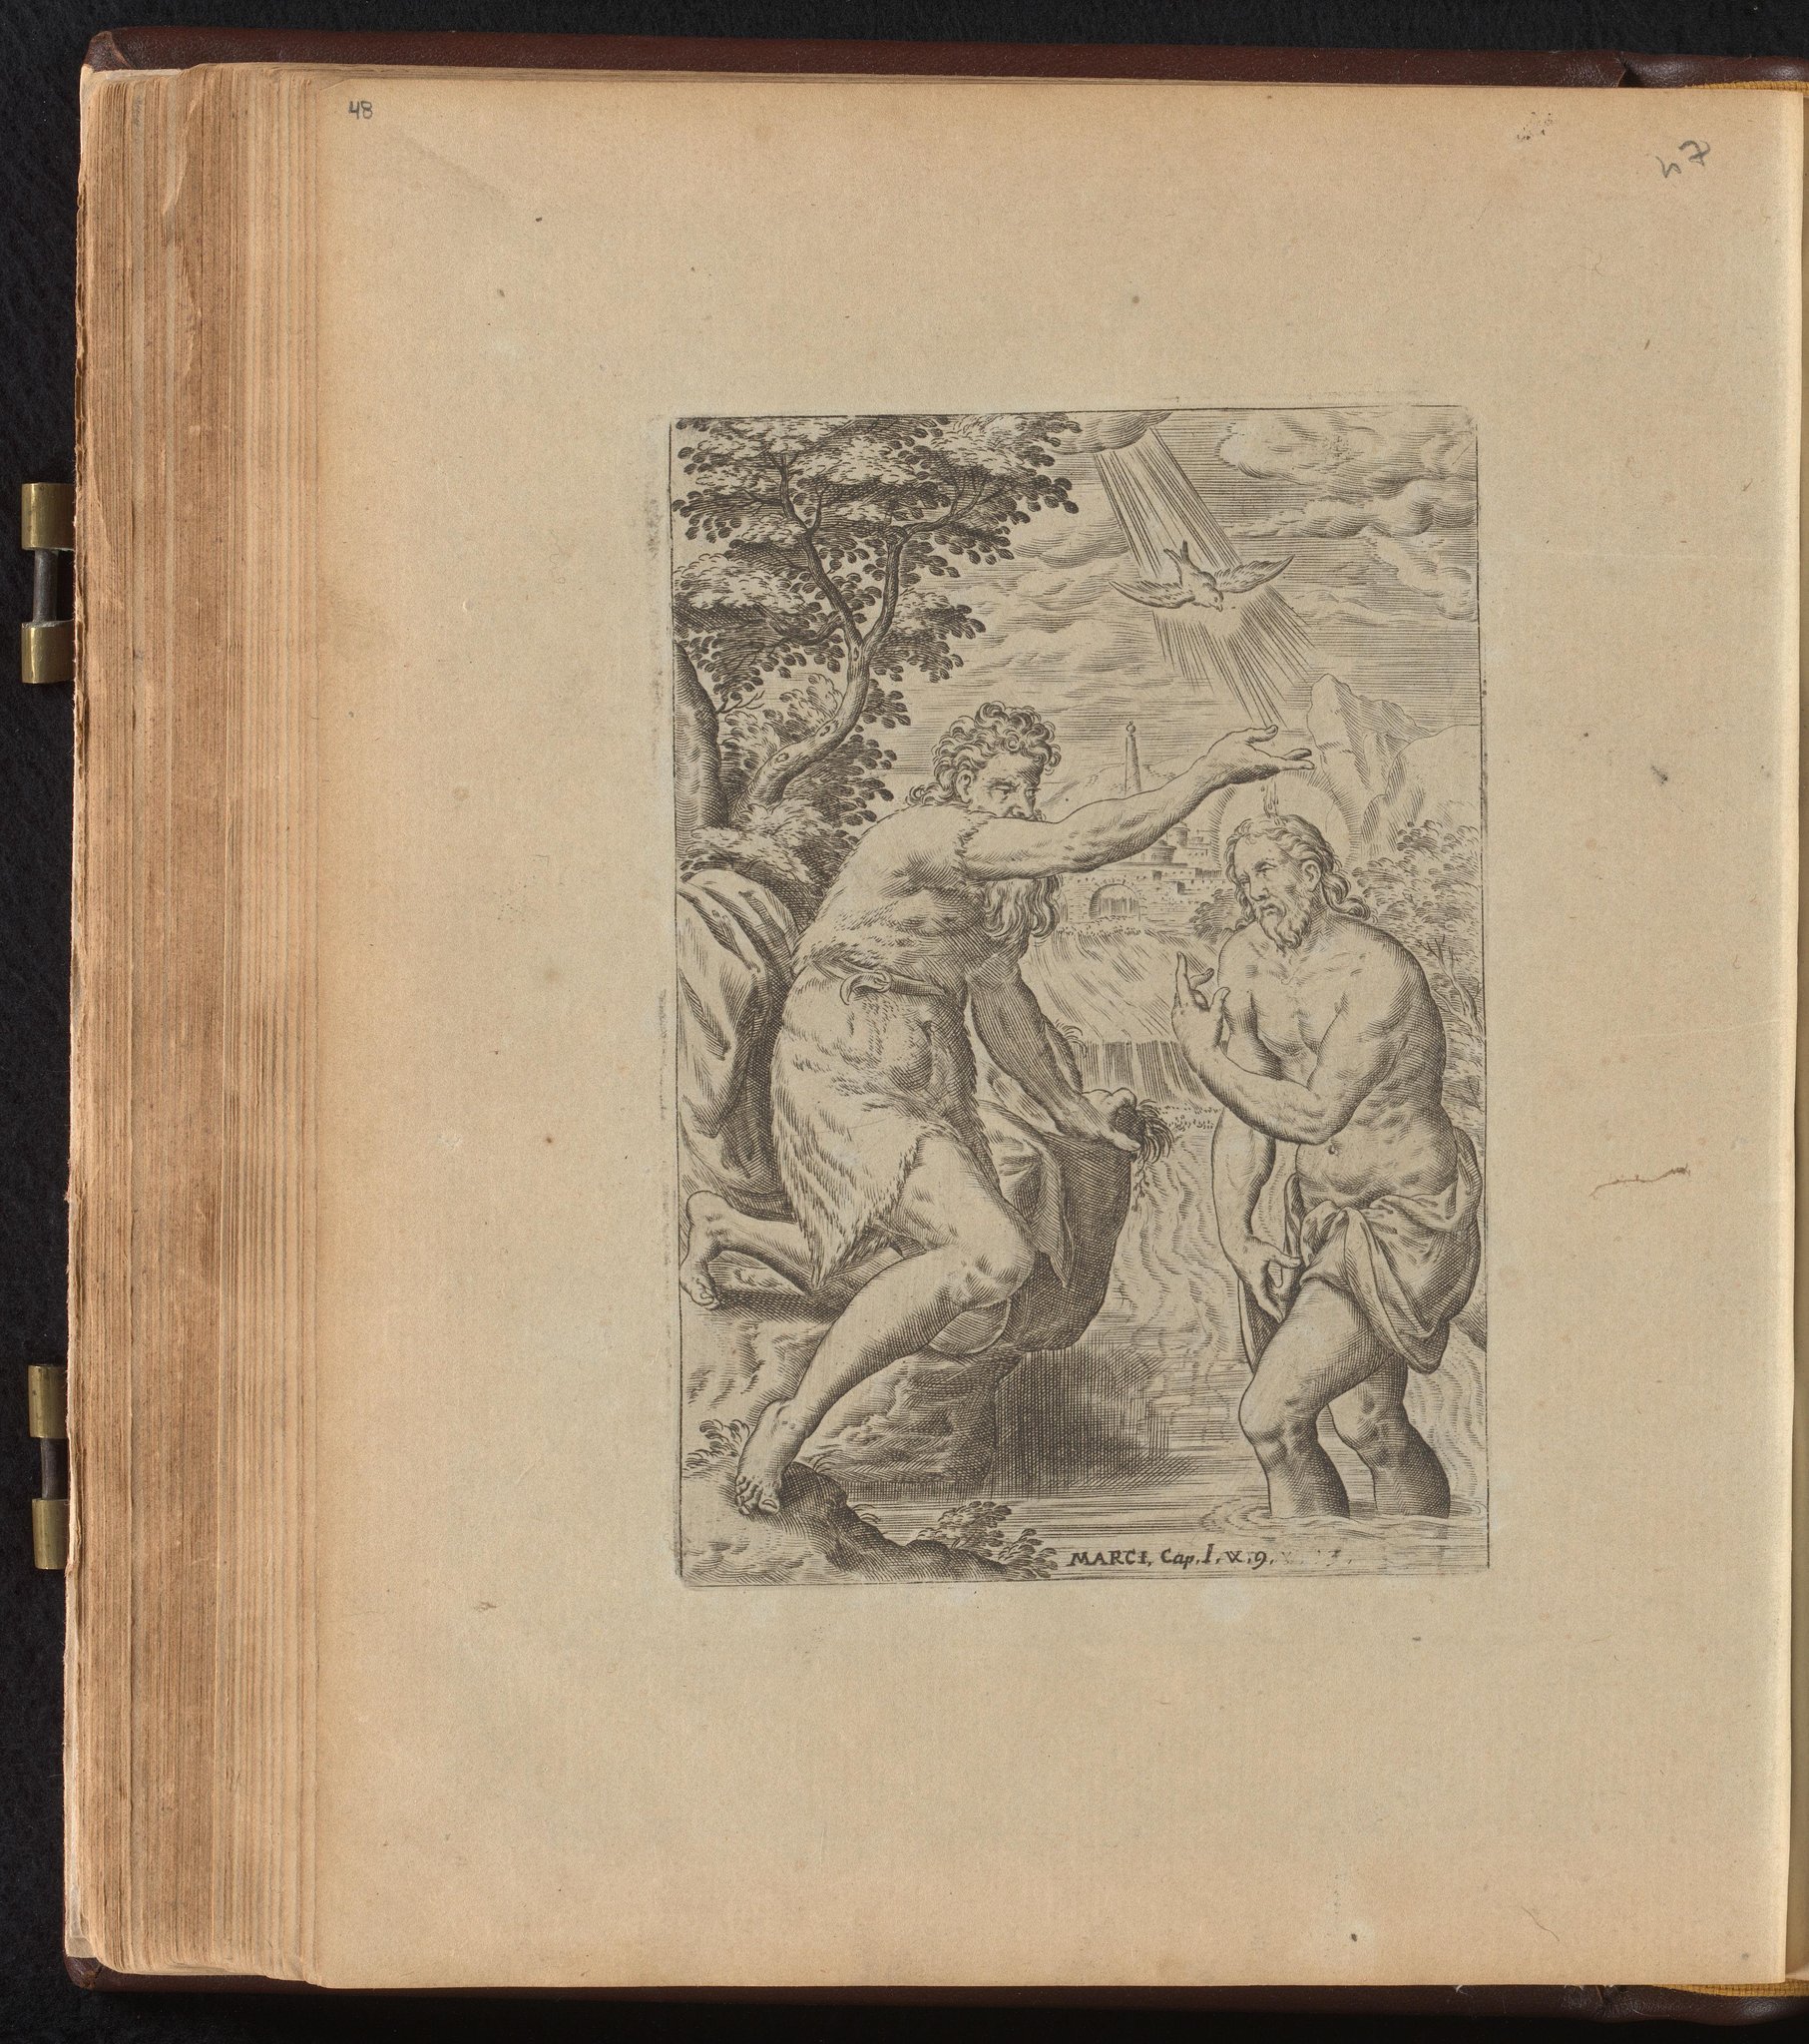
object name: print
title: Doop van Christus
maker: abraham de bruyn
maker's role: print maker, publisher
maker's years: 1540-1587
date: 1583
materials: paper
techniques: engraving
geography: antwerp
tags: baptism of christ in the river jordan: john the baptist pouring out water on christ's head: the holy ghost descends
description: Eerdere staat van prent gebruikt als boekillustratie in: Biblia Sacra. Antwerpen: Christoffel Plantijn, 1583.